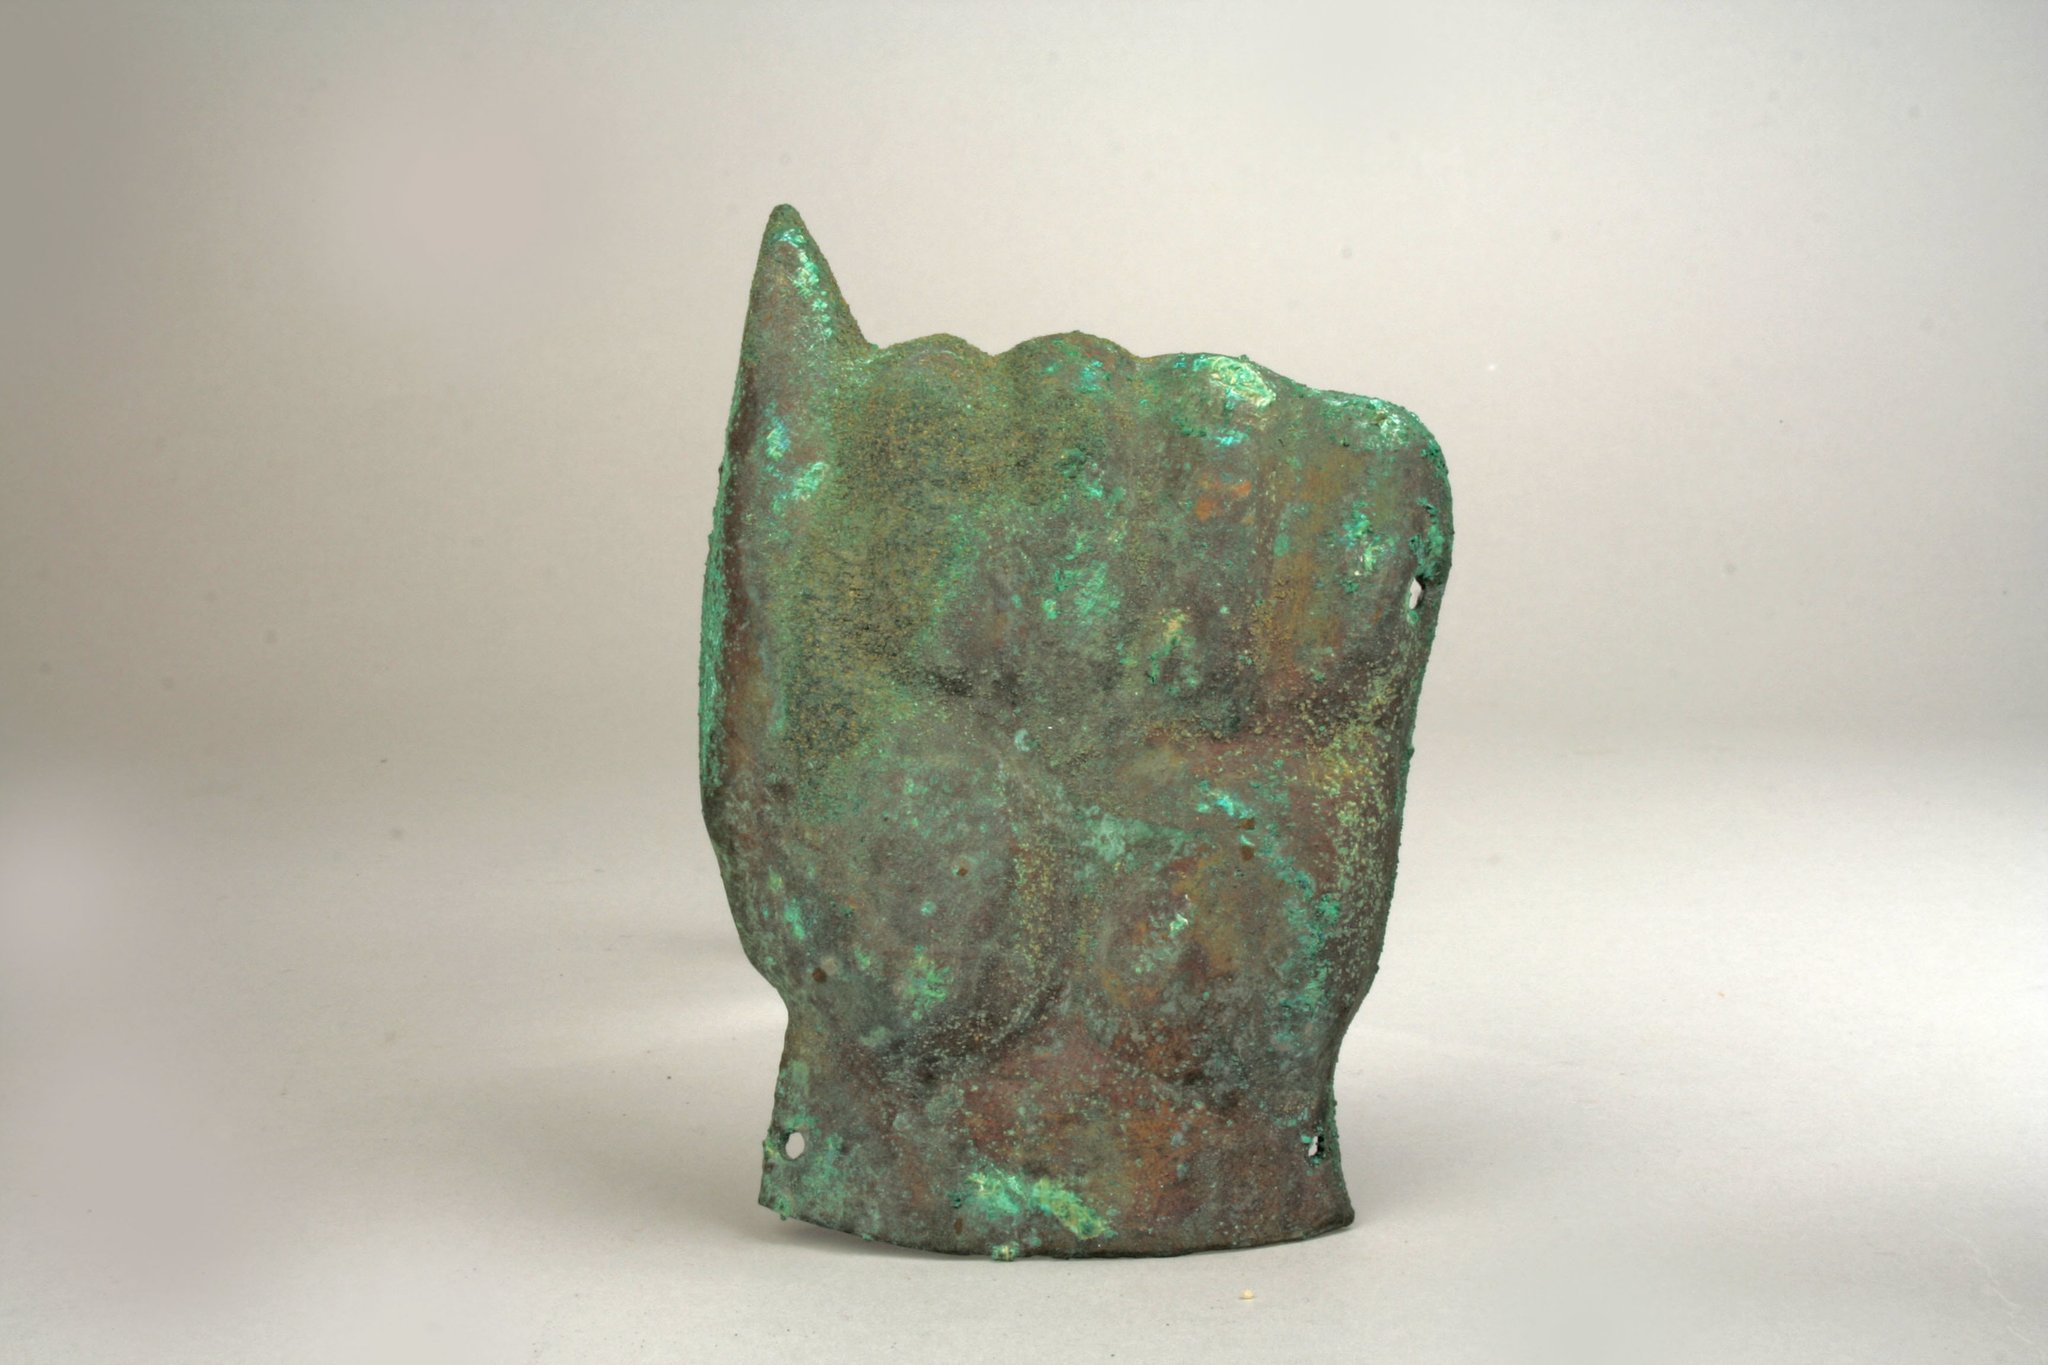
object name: ornament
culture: moche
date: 501-700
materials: gilt copper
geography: peru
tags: hands